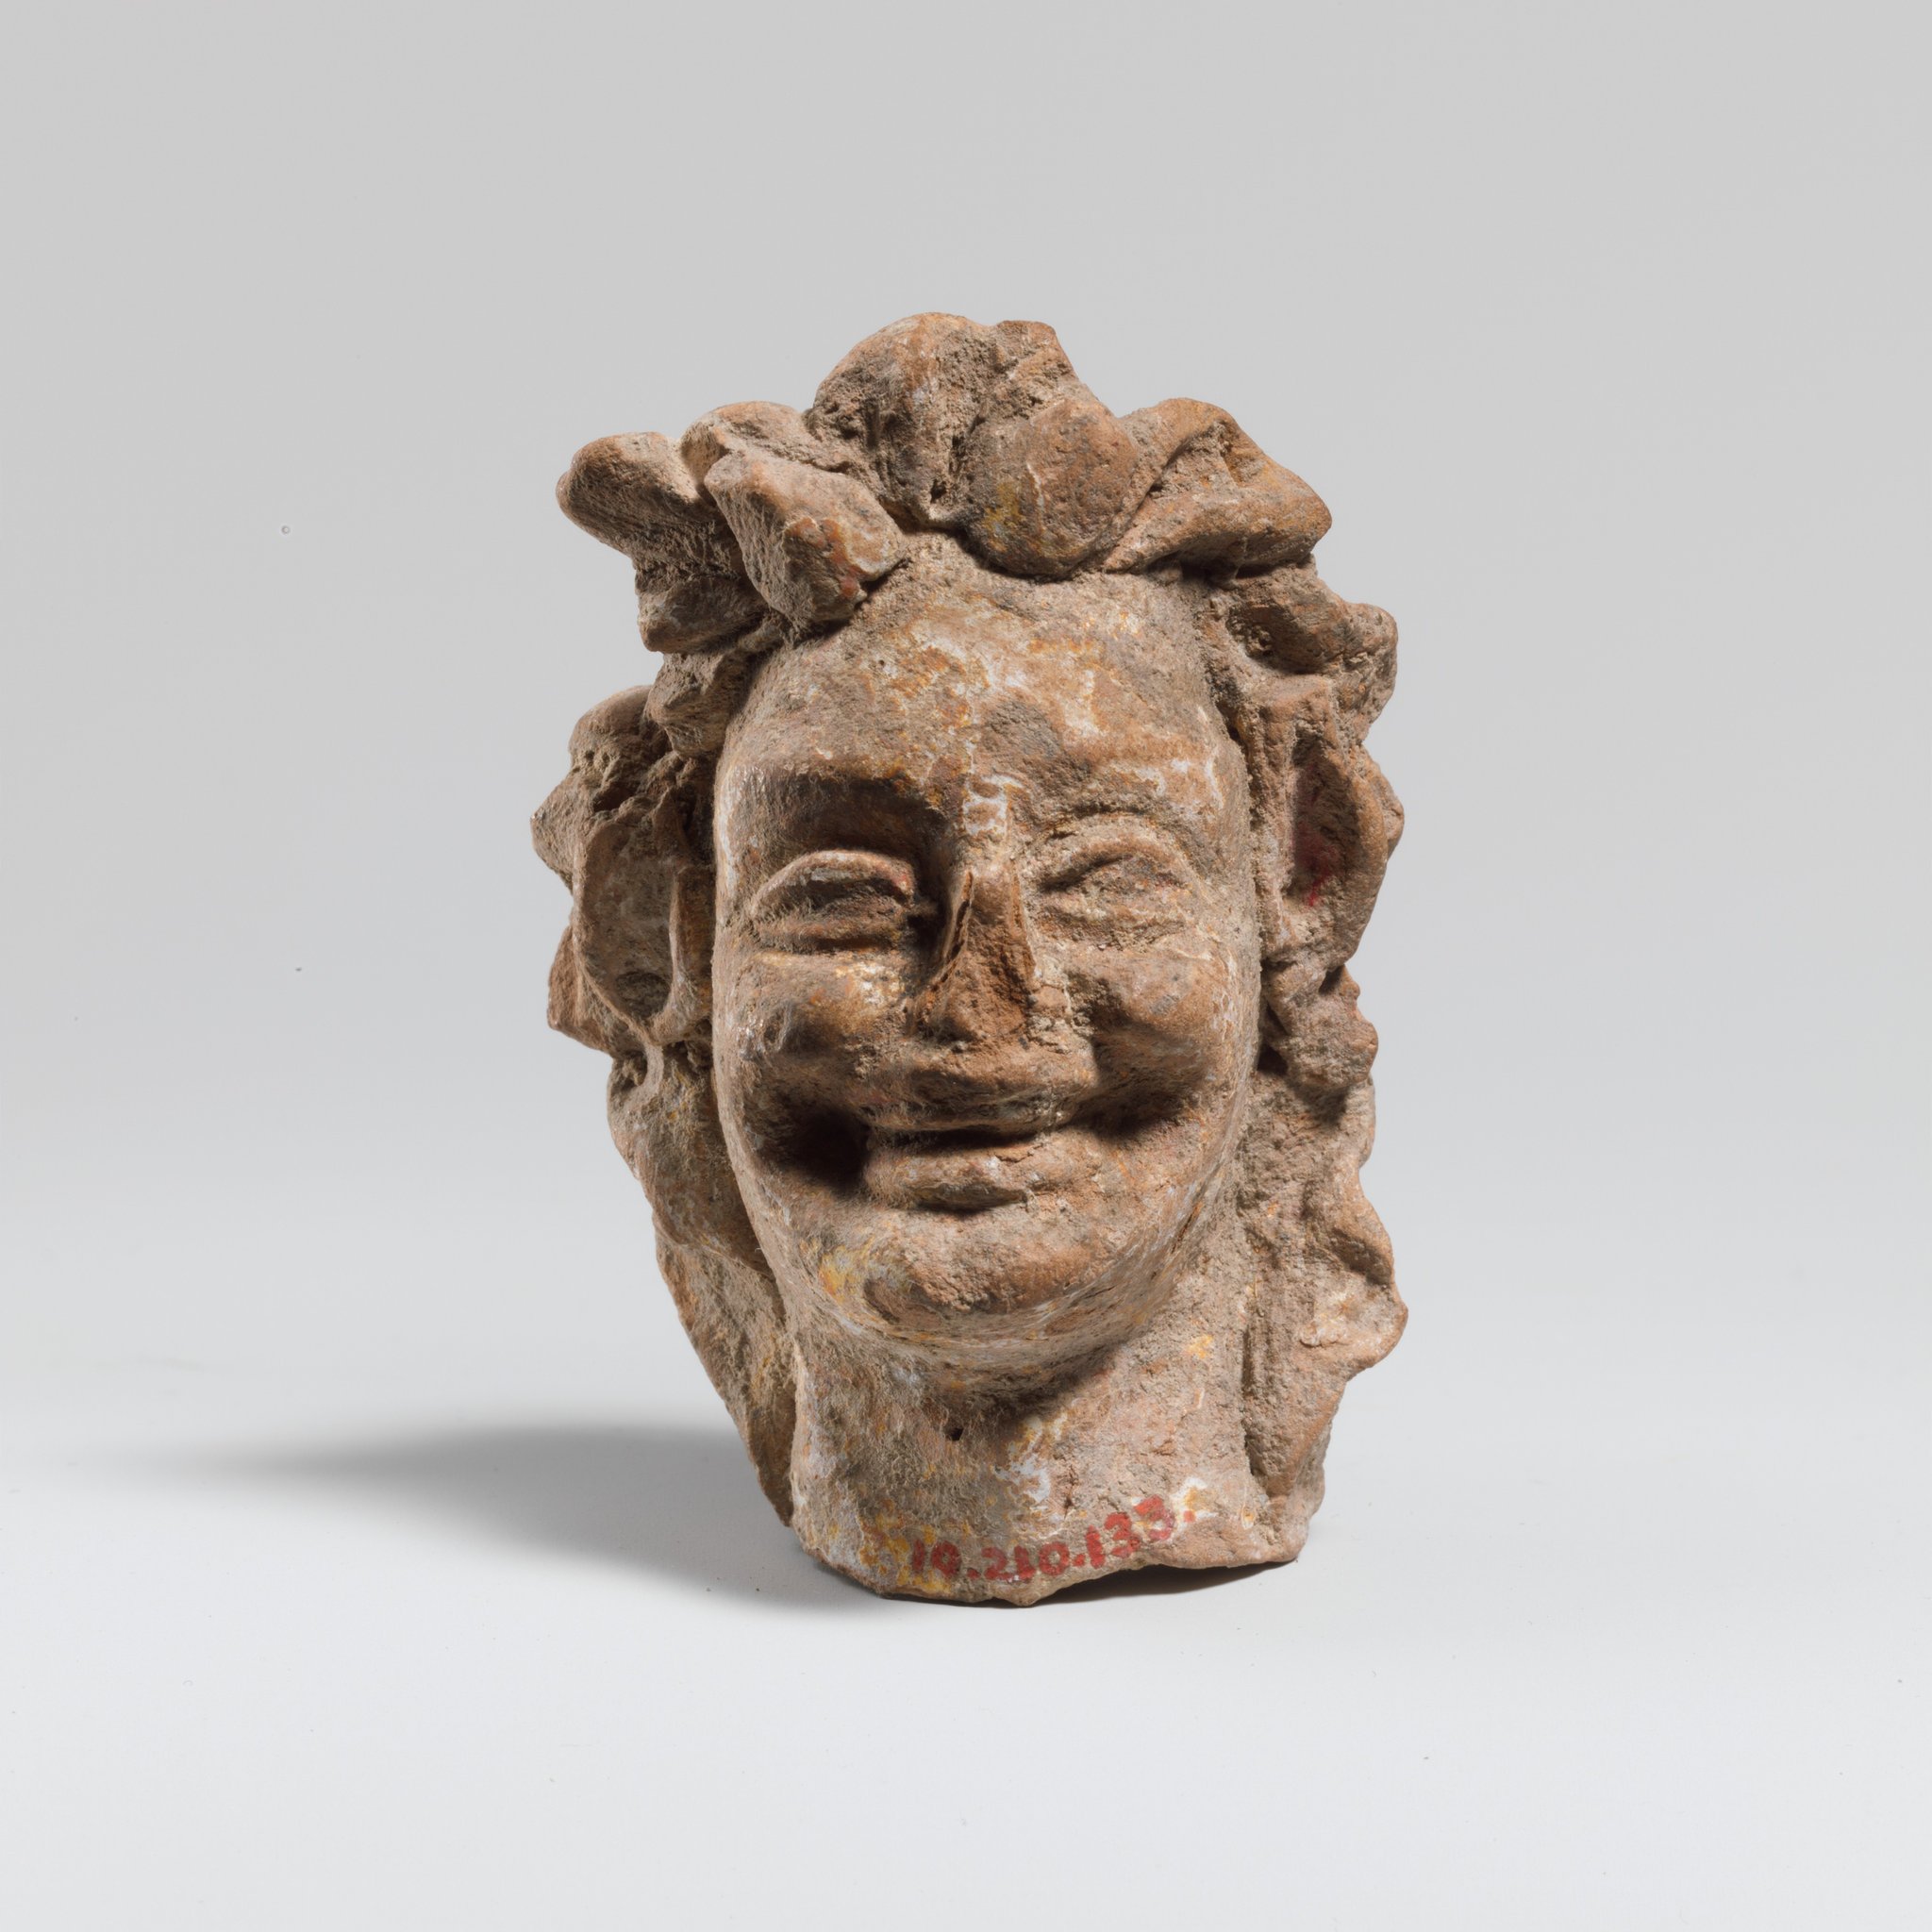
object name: head of a satyr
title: Terracotta head of a laughing satyr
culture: greek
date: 300-1 BCE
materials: terracotta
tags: satyrs